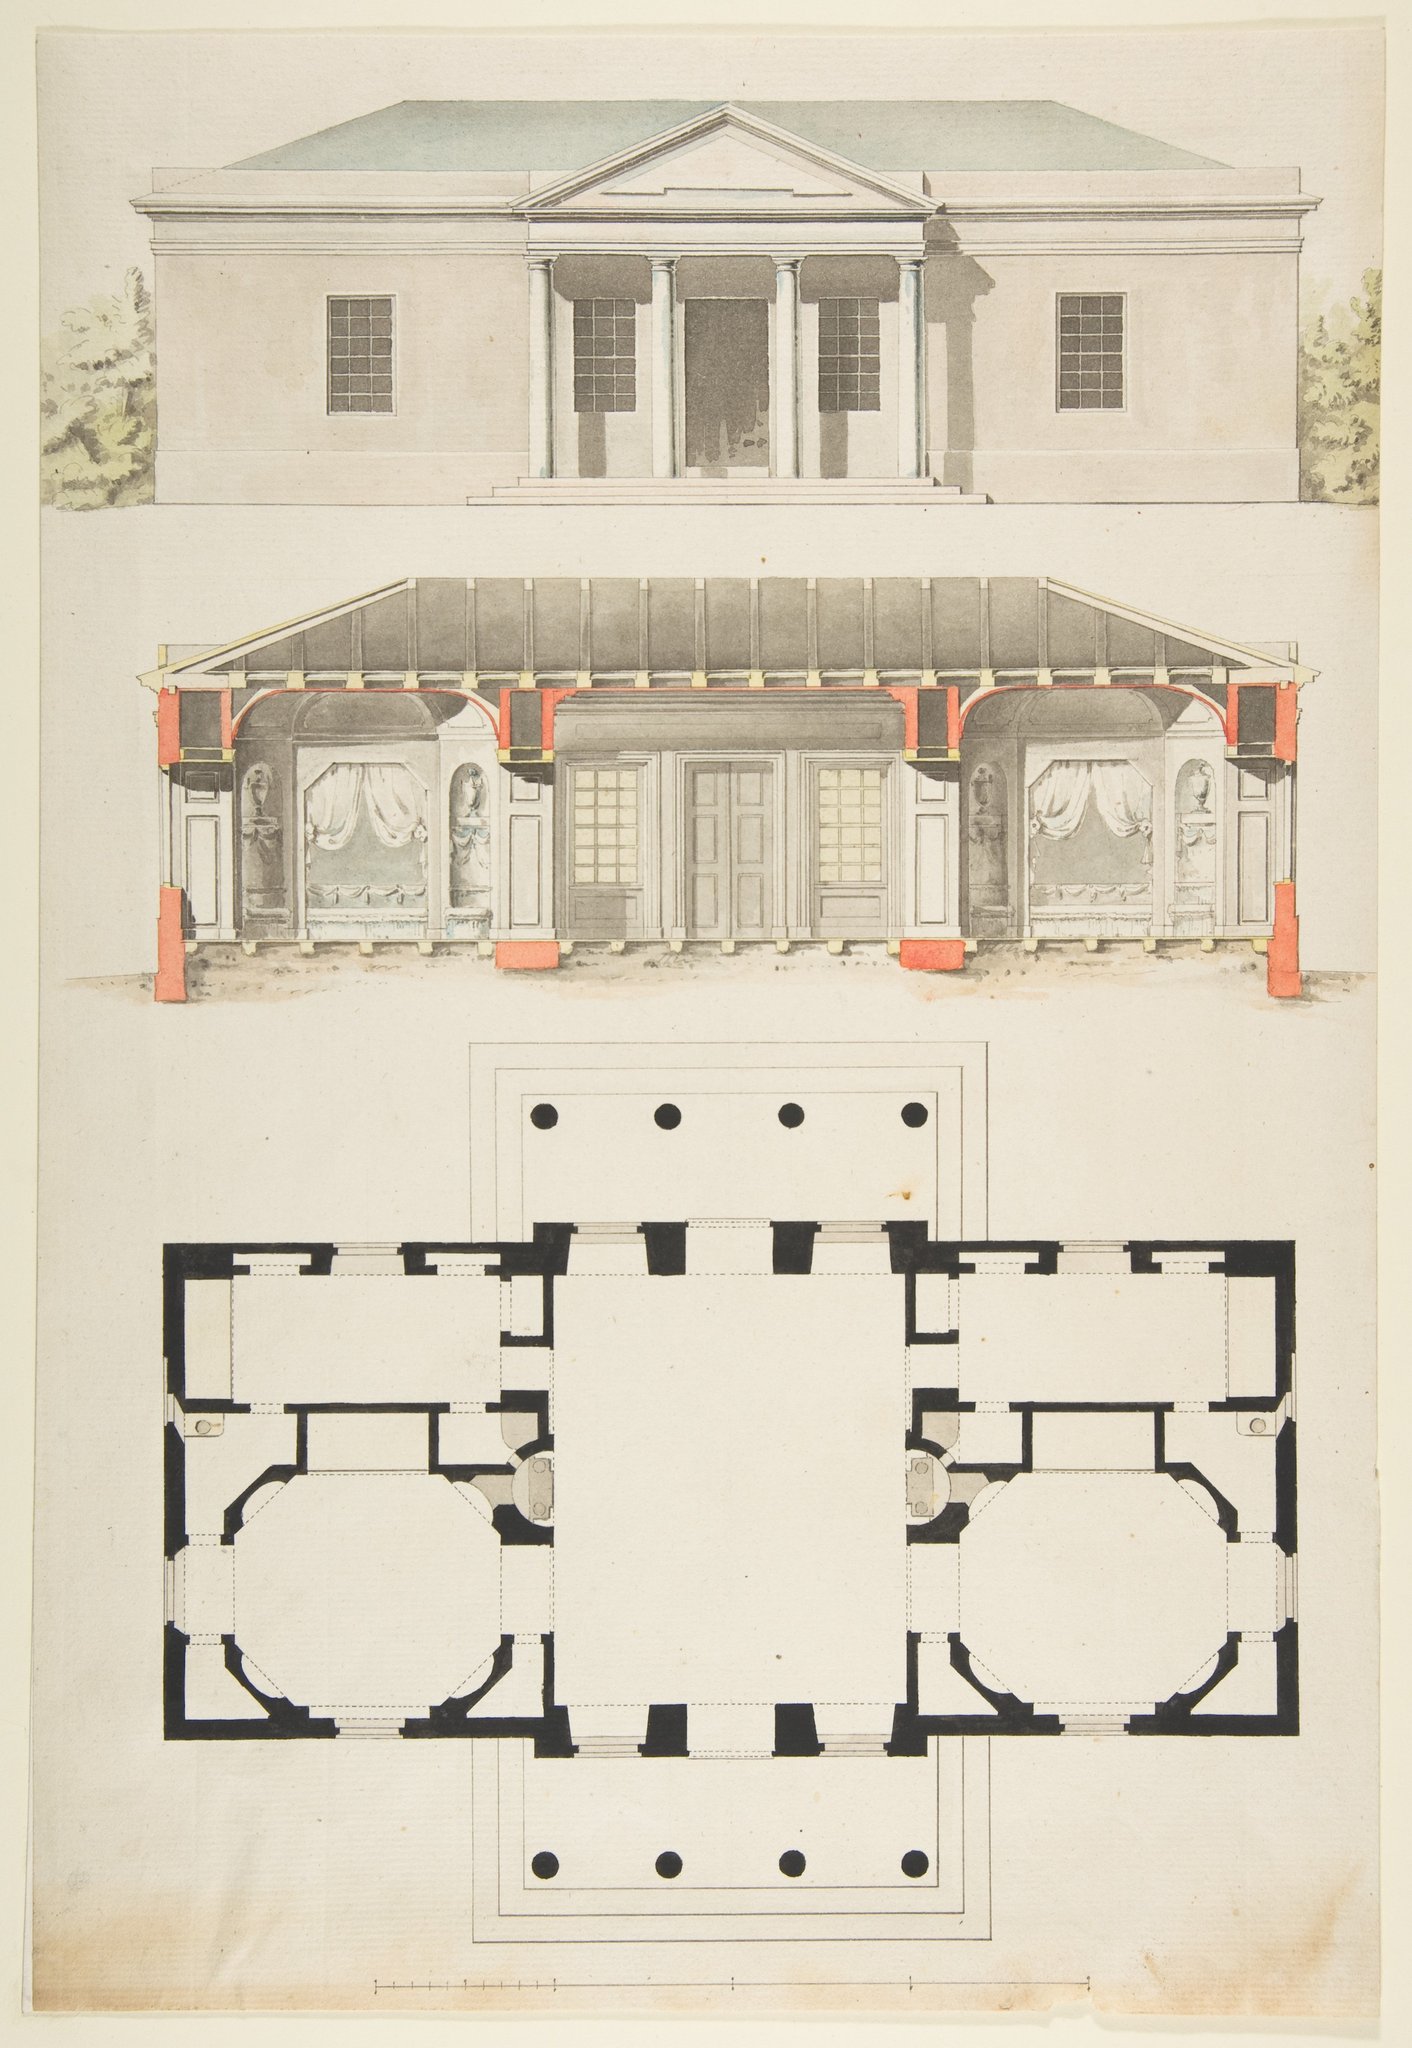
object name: drawing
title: Plan, Elevation, and Section for a Single Story Pavilion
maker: anonymous, french, 18th century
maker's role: artist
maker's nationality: french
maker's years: 1700-1800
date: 1767-1800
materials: ink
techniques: brush, pen, wash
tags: architecture,buildings